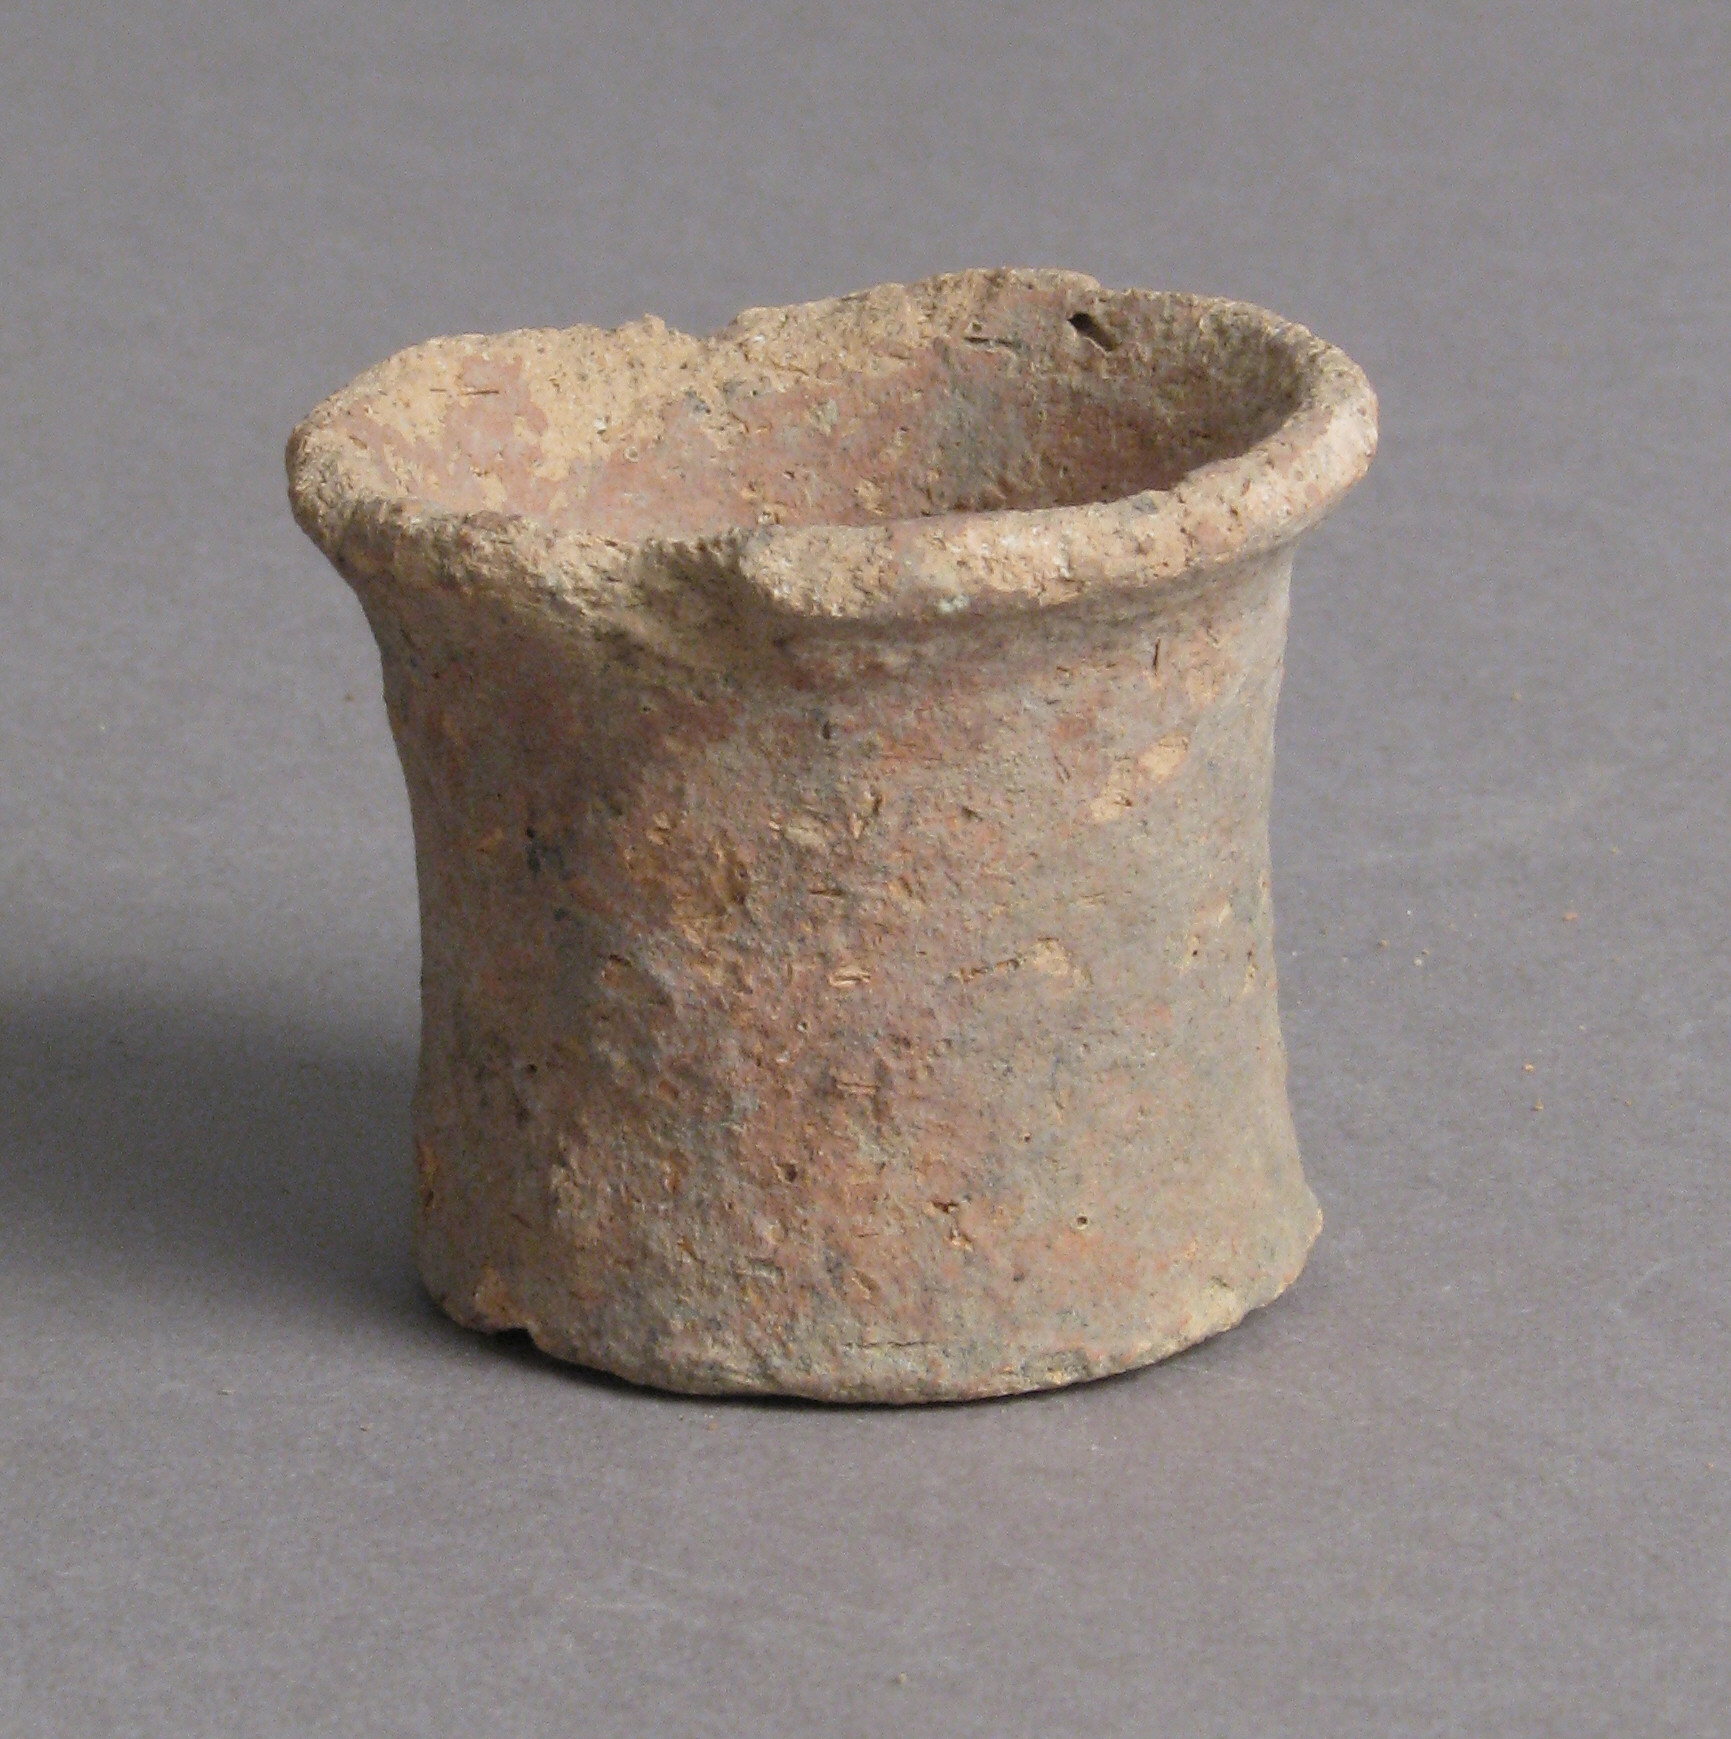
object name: pot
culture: coptic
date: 301-700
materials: earthenware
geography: egypt